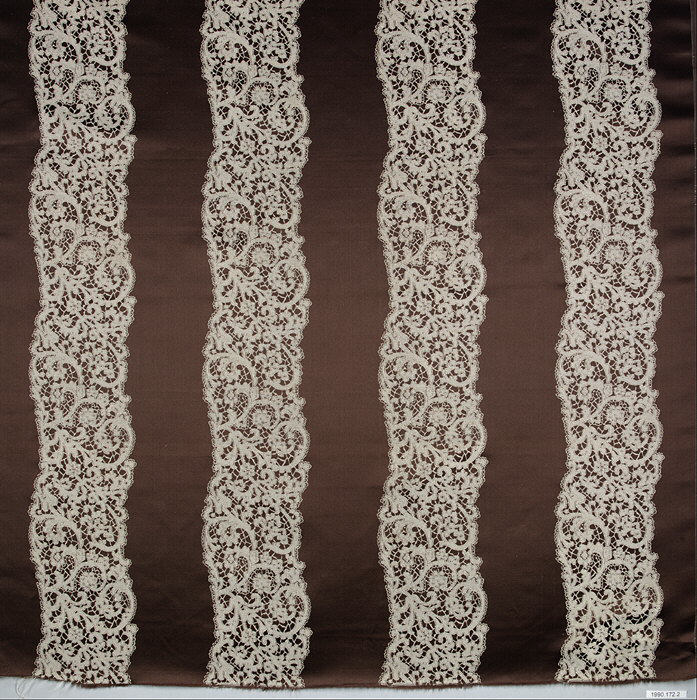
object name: length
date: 1880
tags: flowers